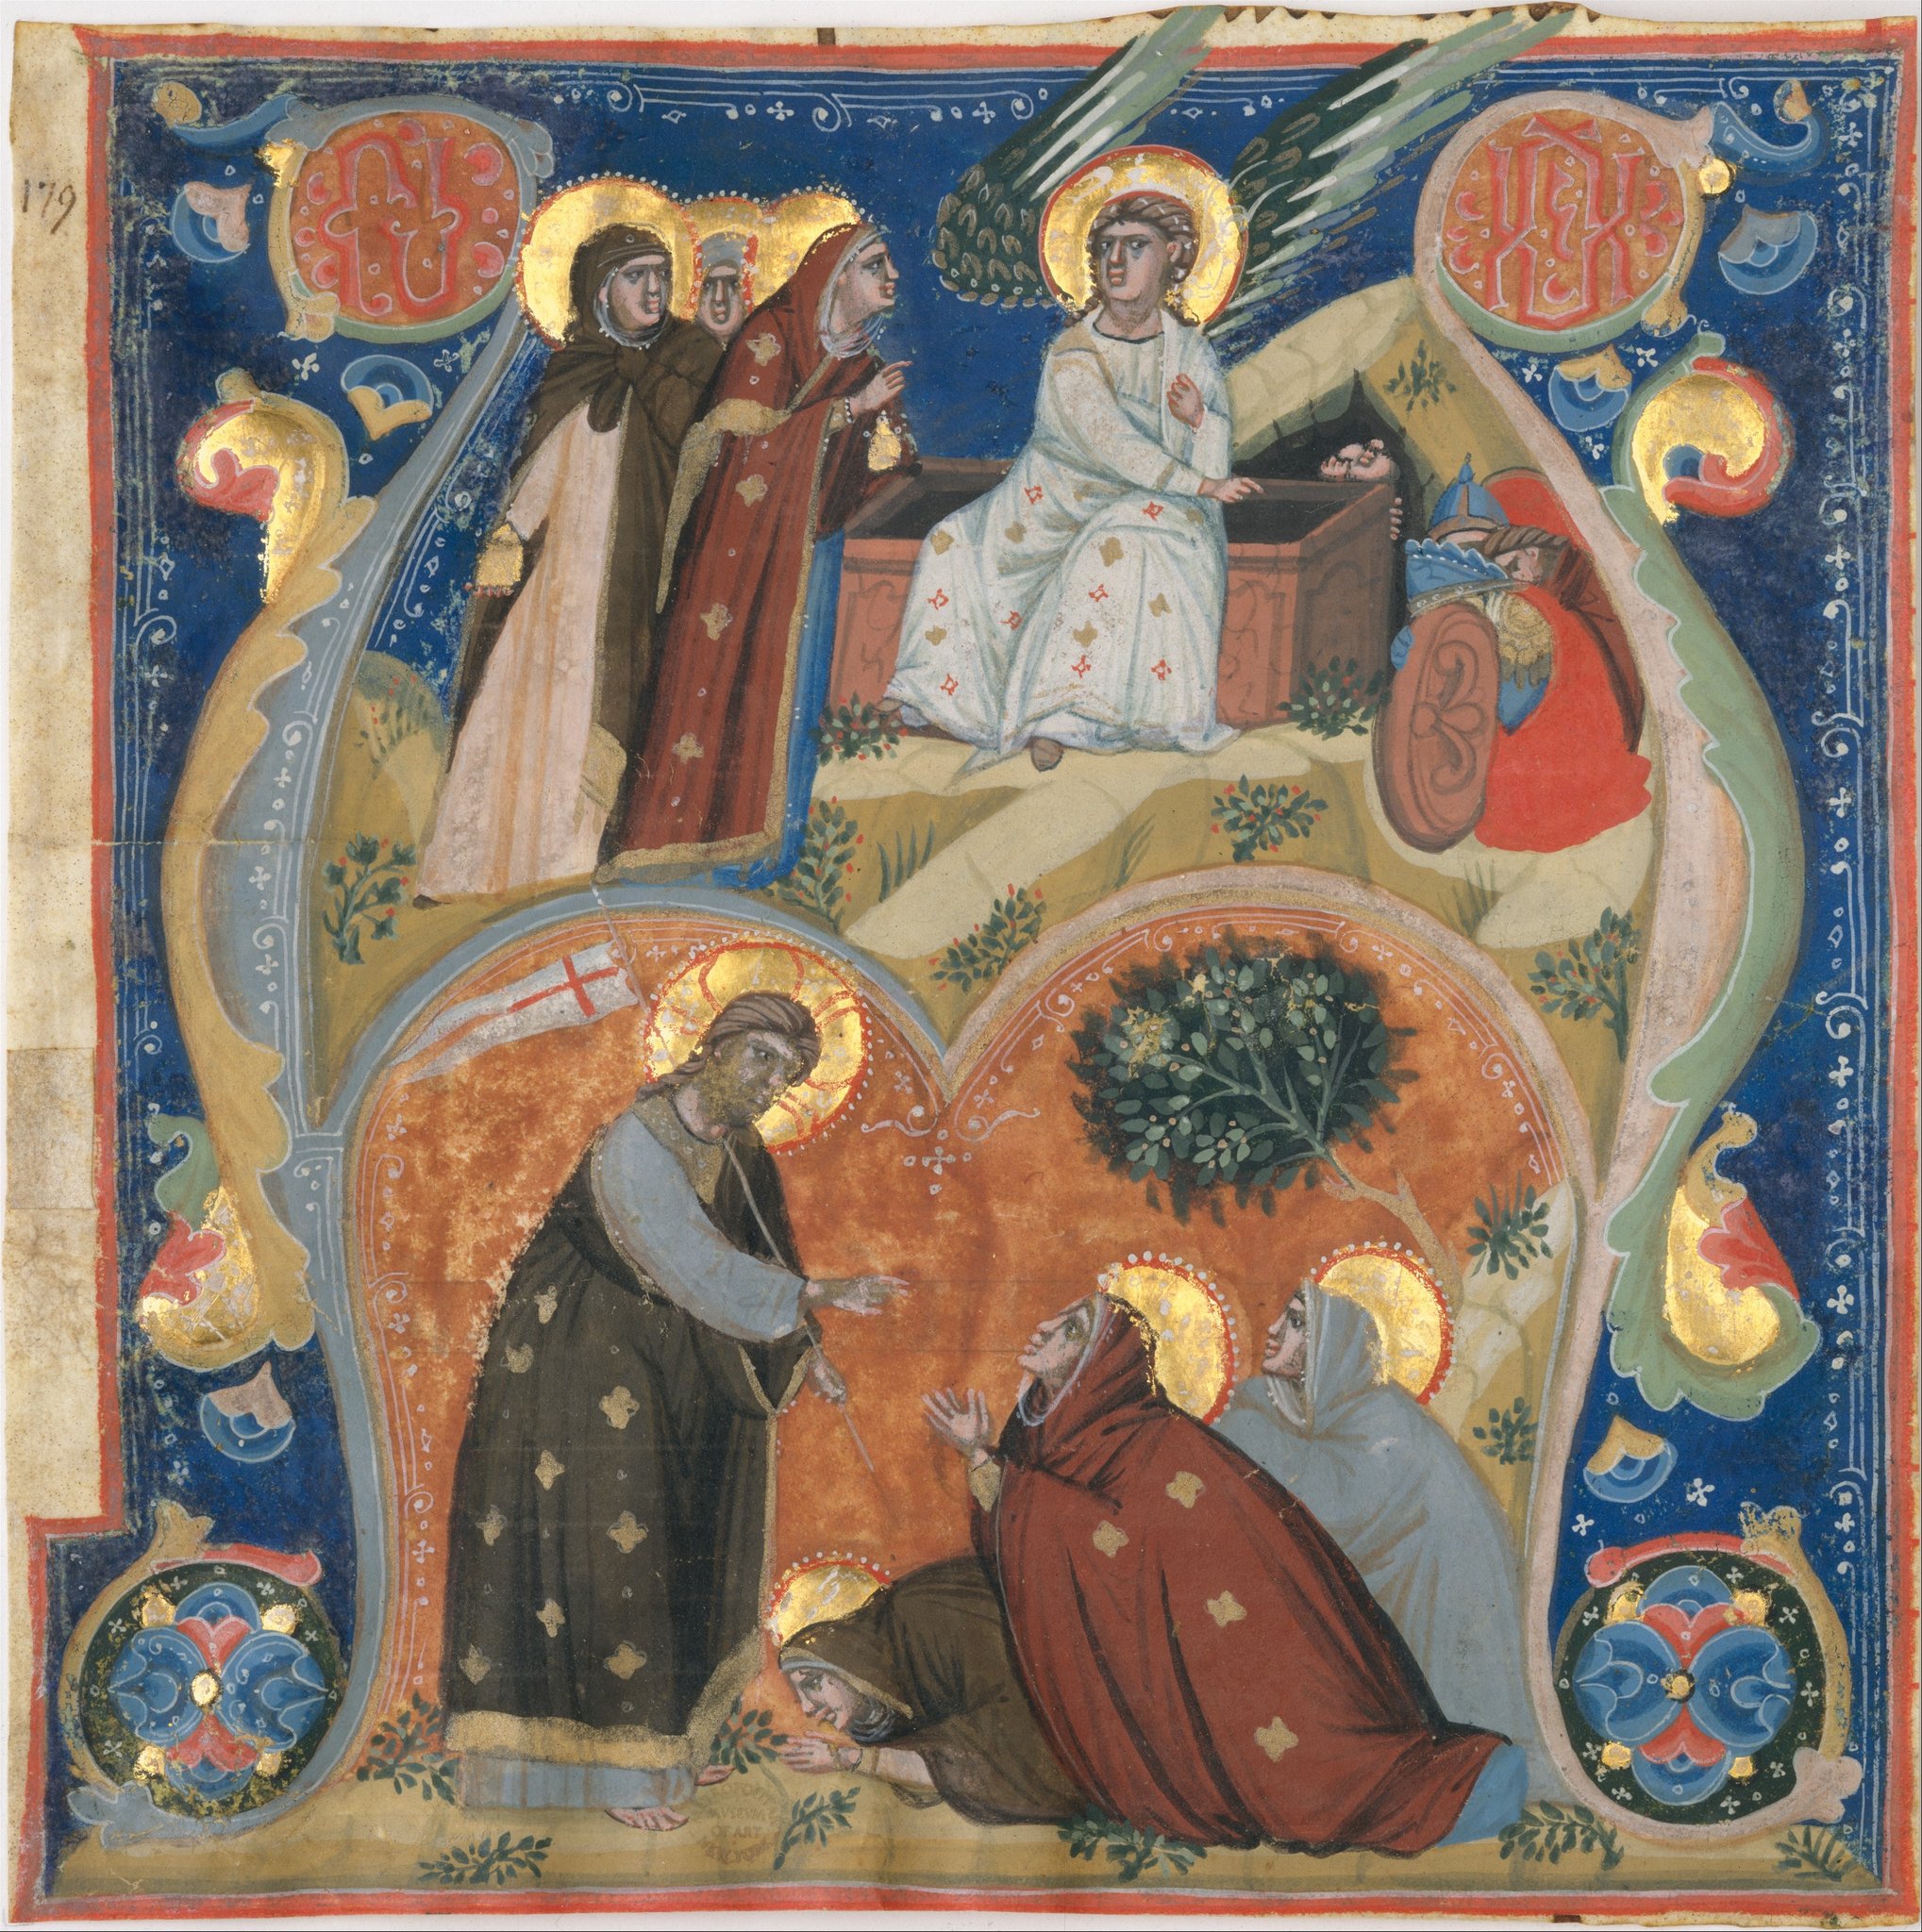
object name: antiphonary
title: Manuscript Illumination with Scenes of Easter in an Initial A, from an Antiphonary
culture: italian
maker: nerius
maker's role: artist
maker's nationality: italian, bolognese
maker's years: 1310-1325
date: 1320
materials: gold, ink, parchment, paint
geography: italy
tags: men,women,angels,christ